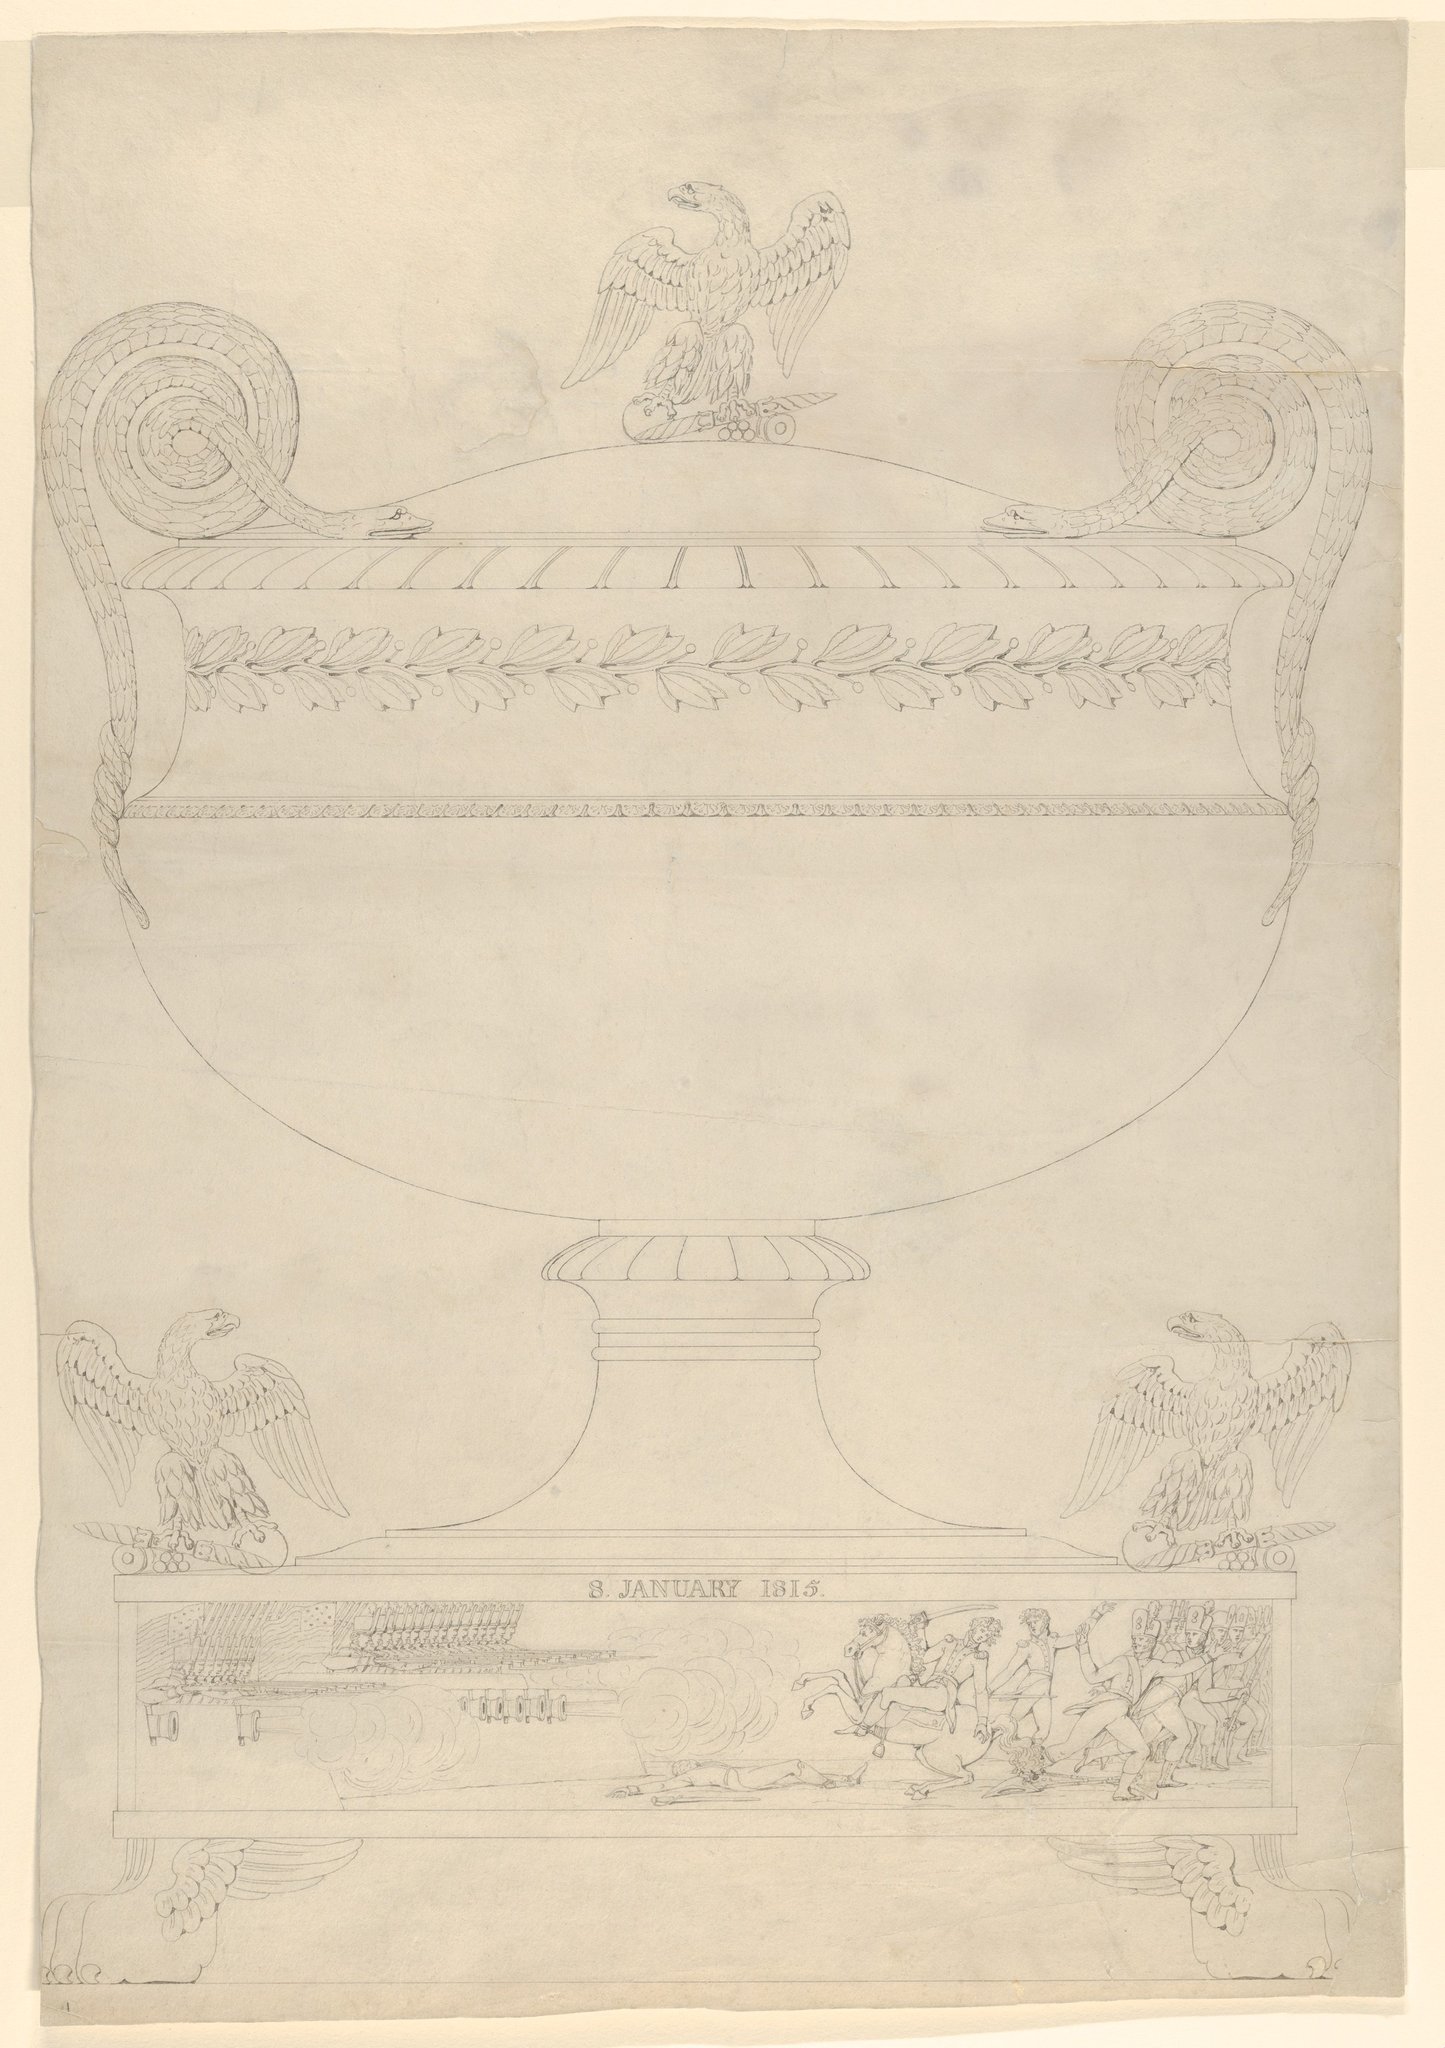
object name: drawing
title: Design for a covered vase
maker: thomas fletcher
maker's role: artist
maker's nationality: american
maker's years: 1787-1866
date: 1815-1817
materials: ink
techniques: pen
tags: birds,weapons,horses,vases